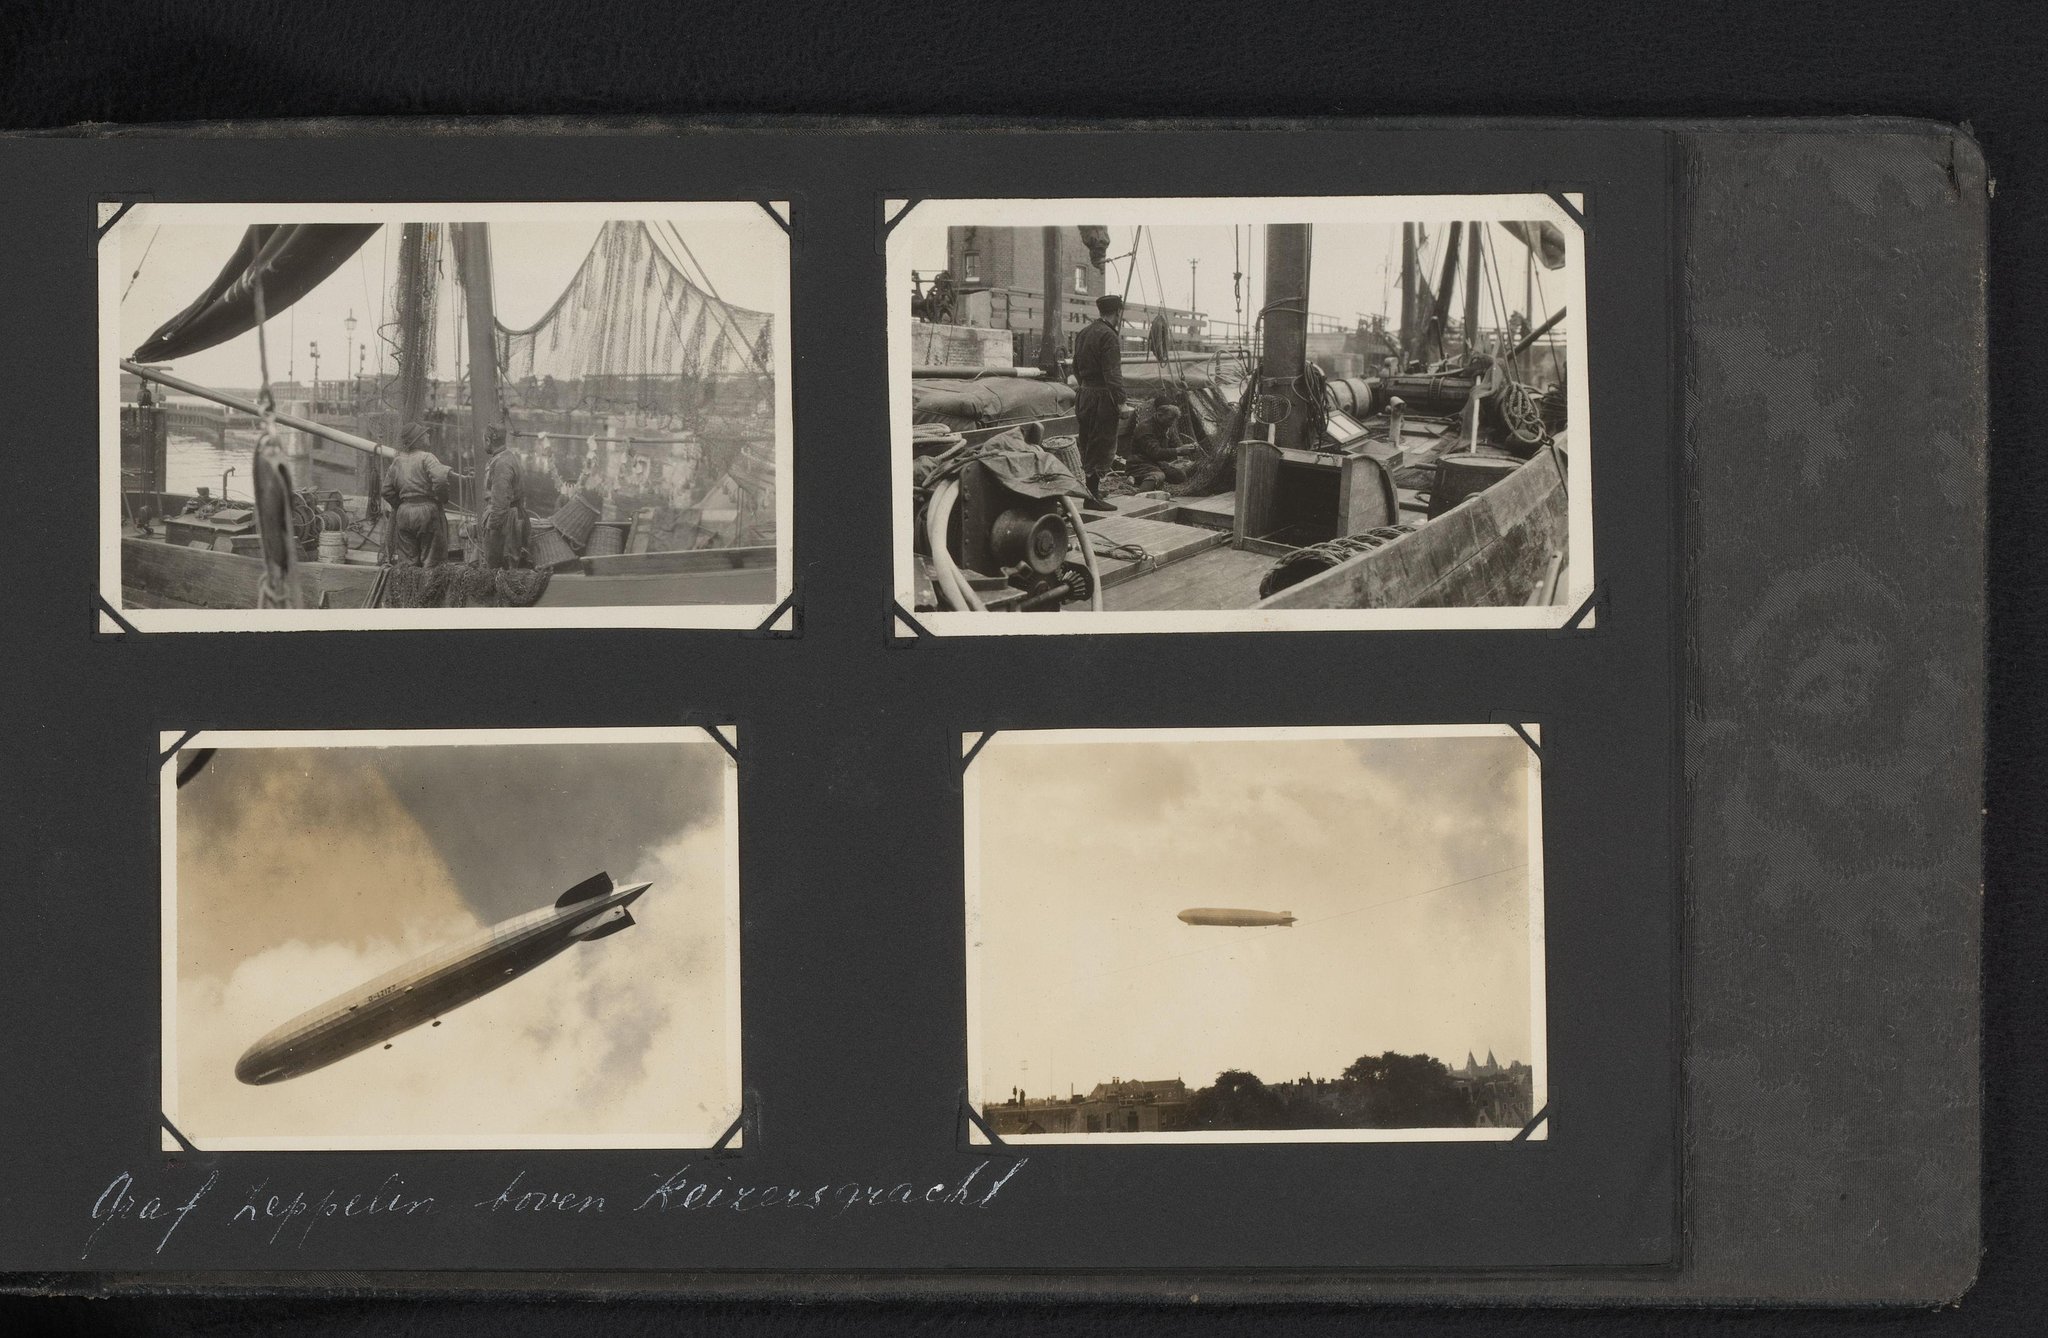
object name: album leaf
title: Vier foto's van vissersboten en de Graf Zeppelin boven Amsterdam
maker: hendrik herman van den berg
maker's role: amateurfotograaf, jurist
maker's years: 1875-1944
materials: paper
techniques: gelatin silver print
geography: netherlands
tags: commercial fishery, 46c35 airship, zeppelin, netherlands, amsterdam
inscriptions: inscription: ‘Graf Zeppelin boven Keizersgracht’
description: Deze foto's maken deel uit van een album.